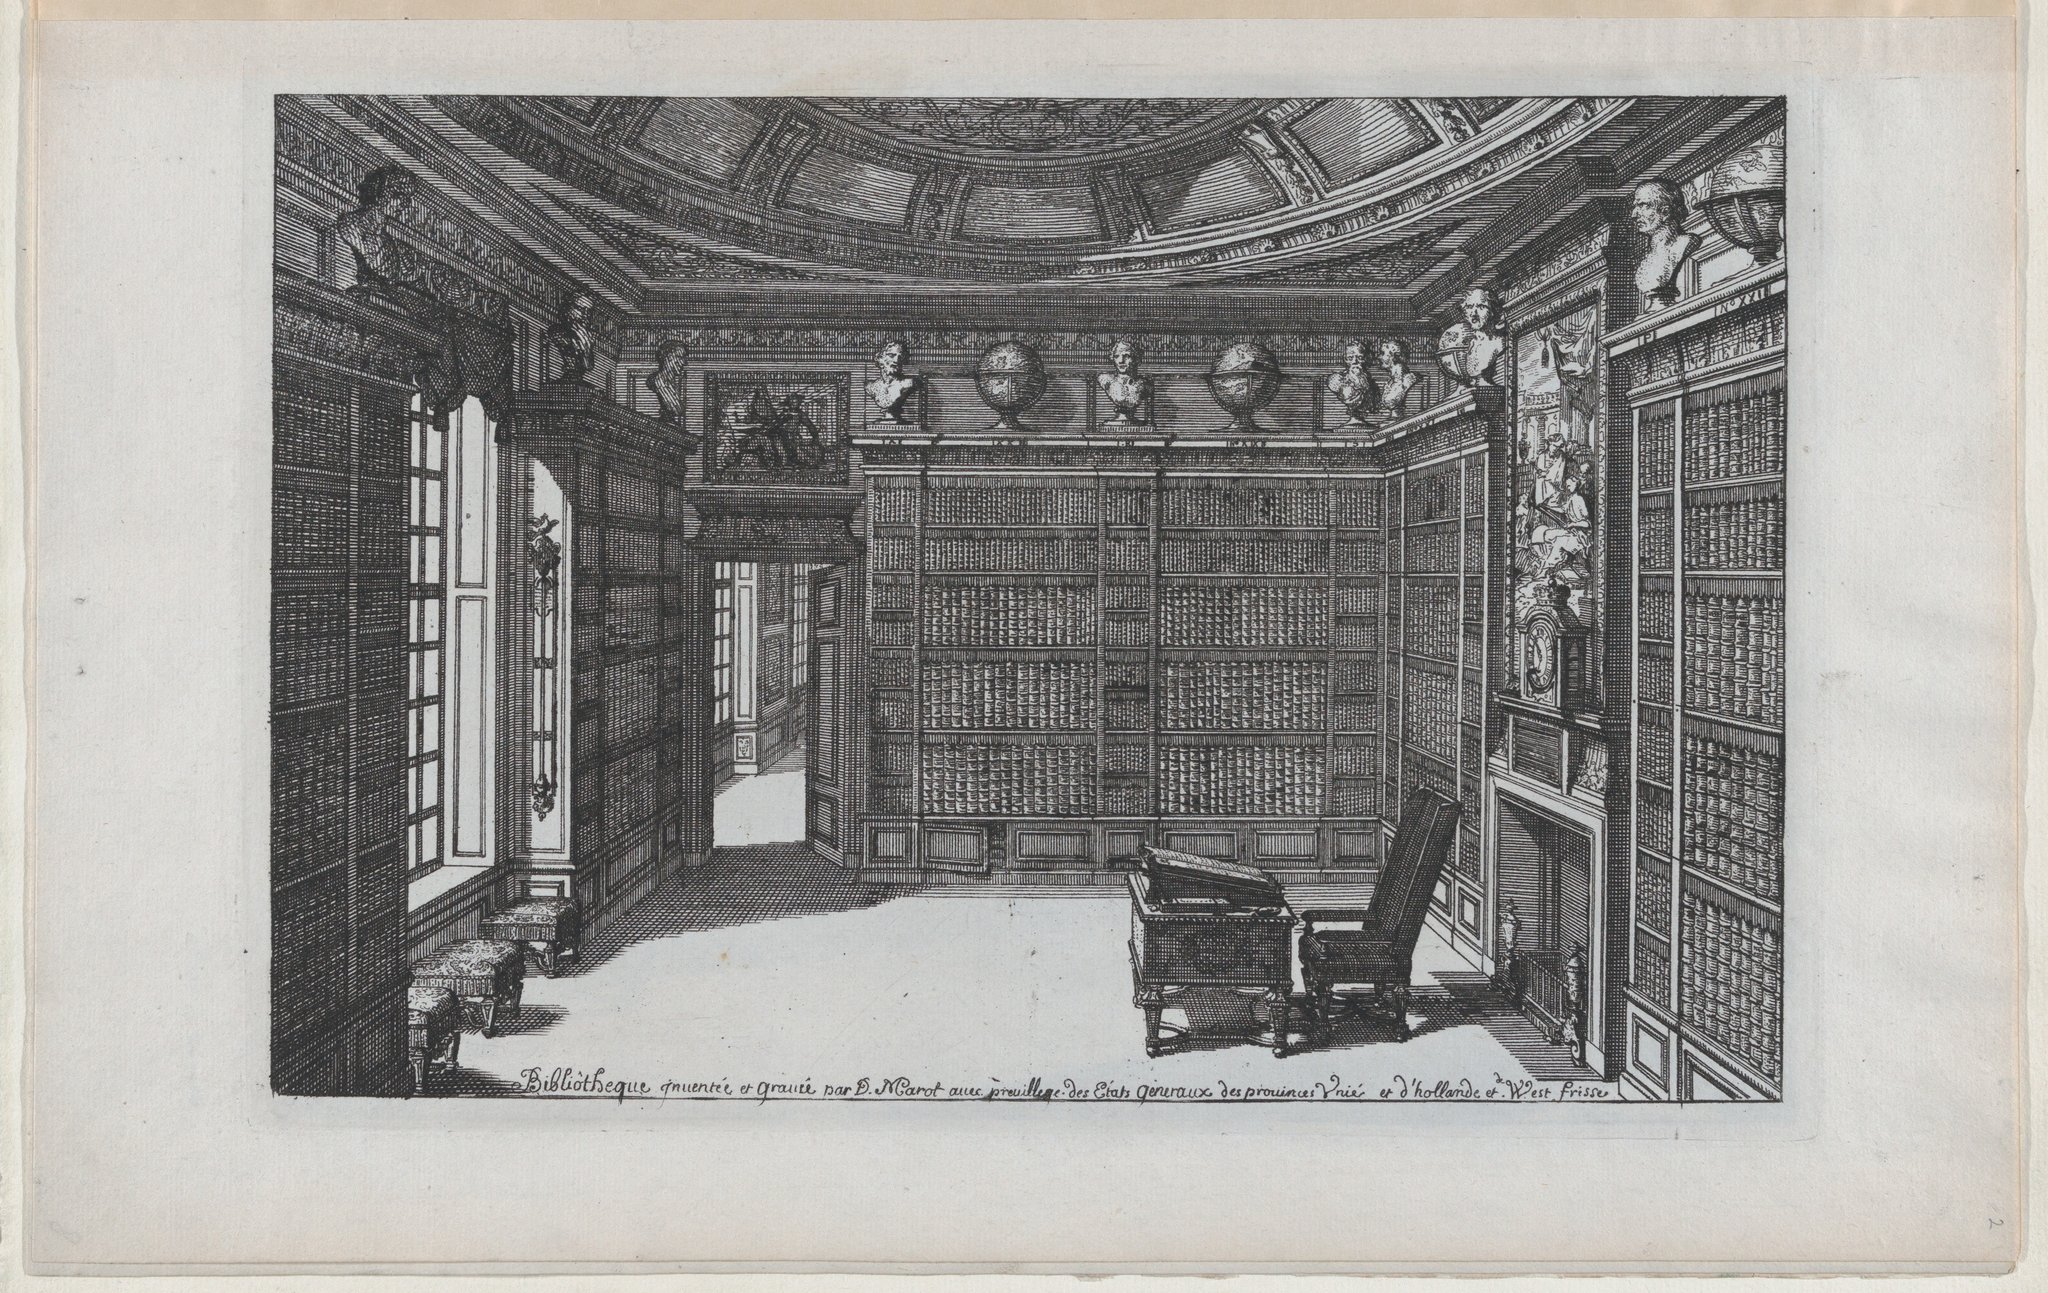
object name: print collection ornament architecture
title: Interior of a Library, from Nouveaux Liure da Partements, part of Œuvres du Sr. D. Marot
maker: daniel marot the elder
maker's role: artist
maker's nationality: french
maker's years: 1661-1752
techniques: etching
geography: netherlands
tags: libraries,interiors